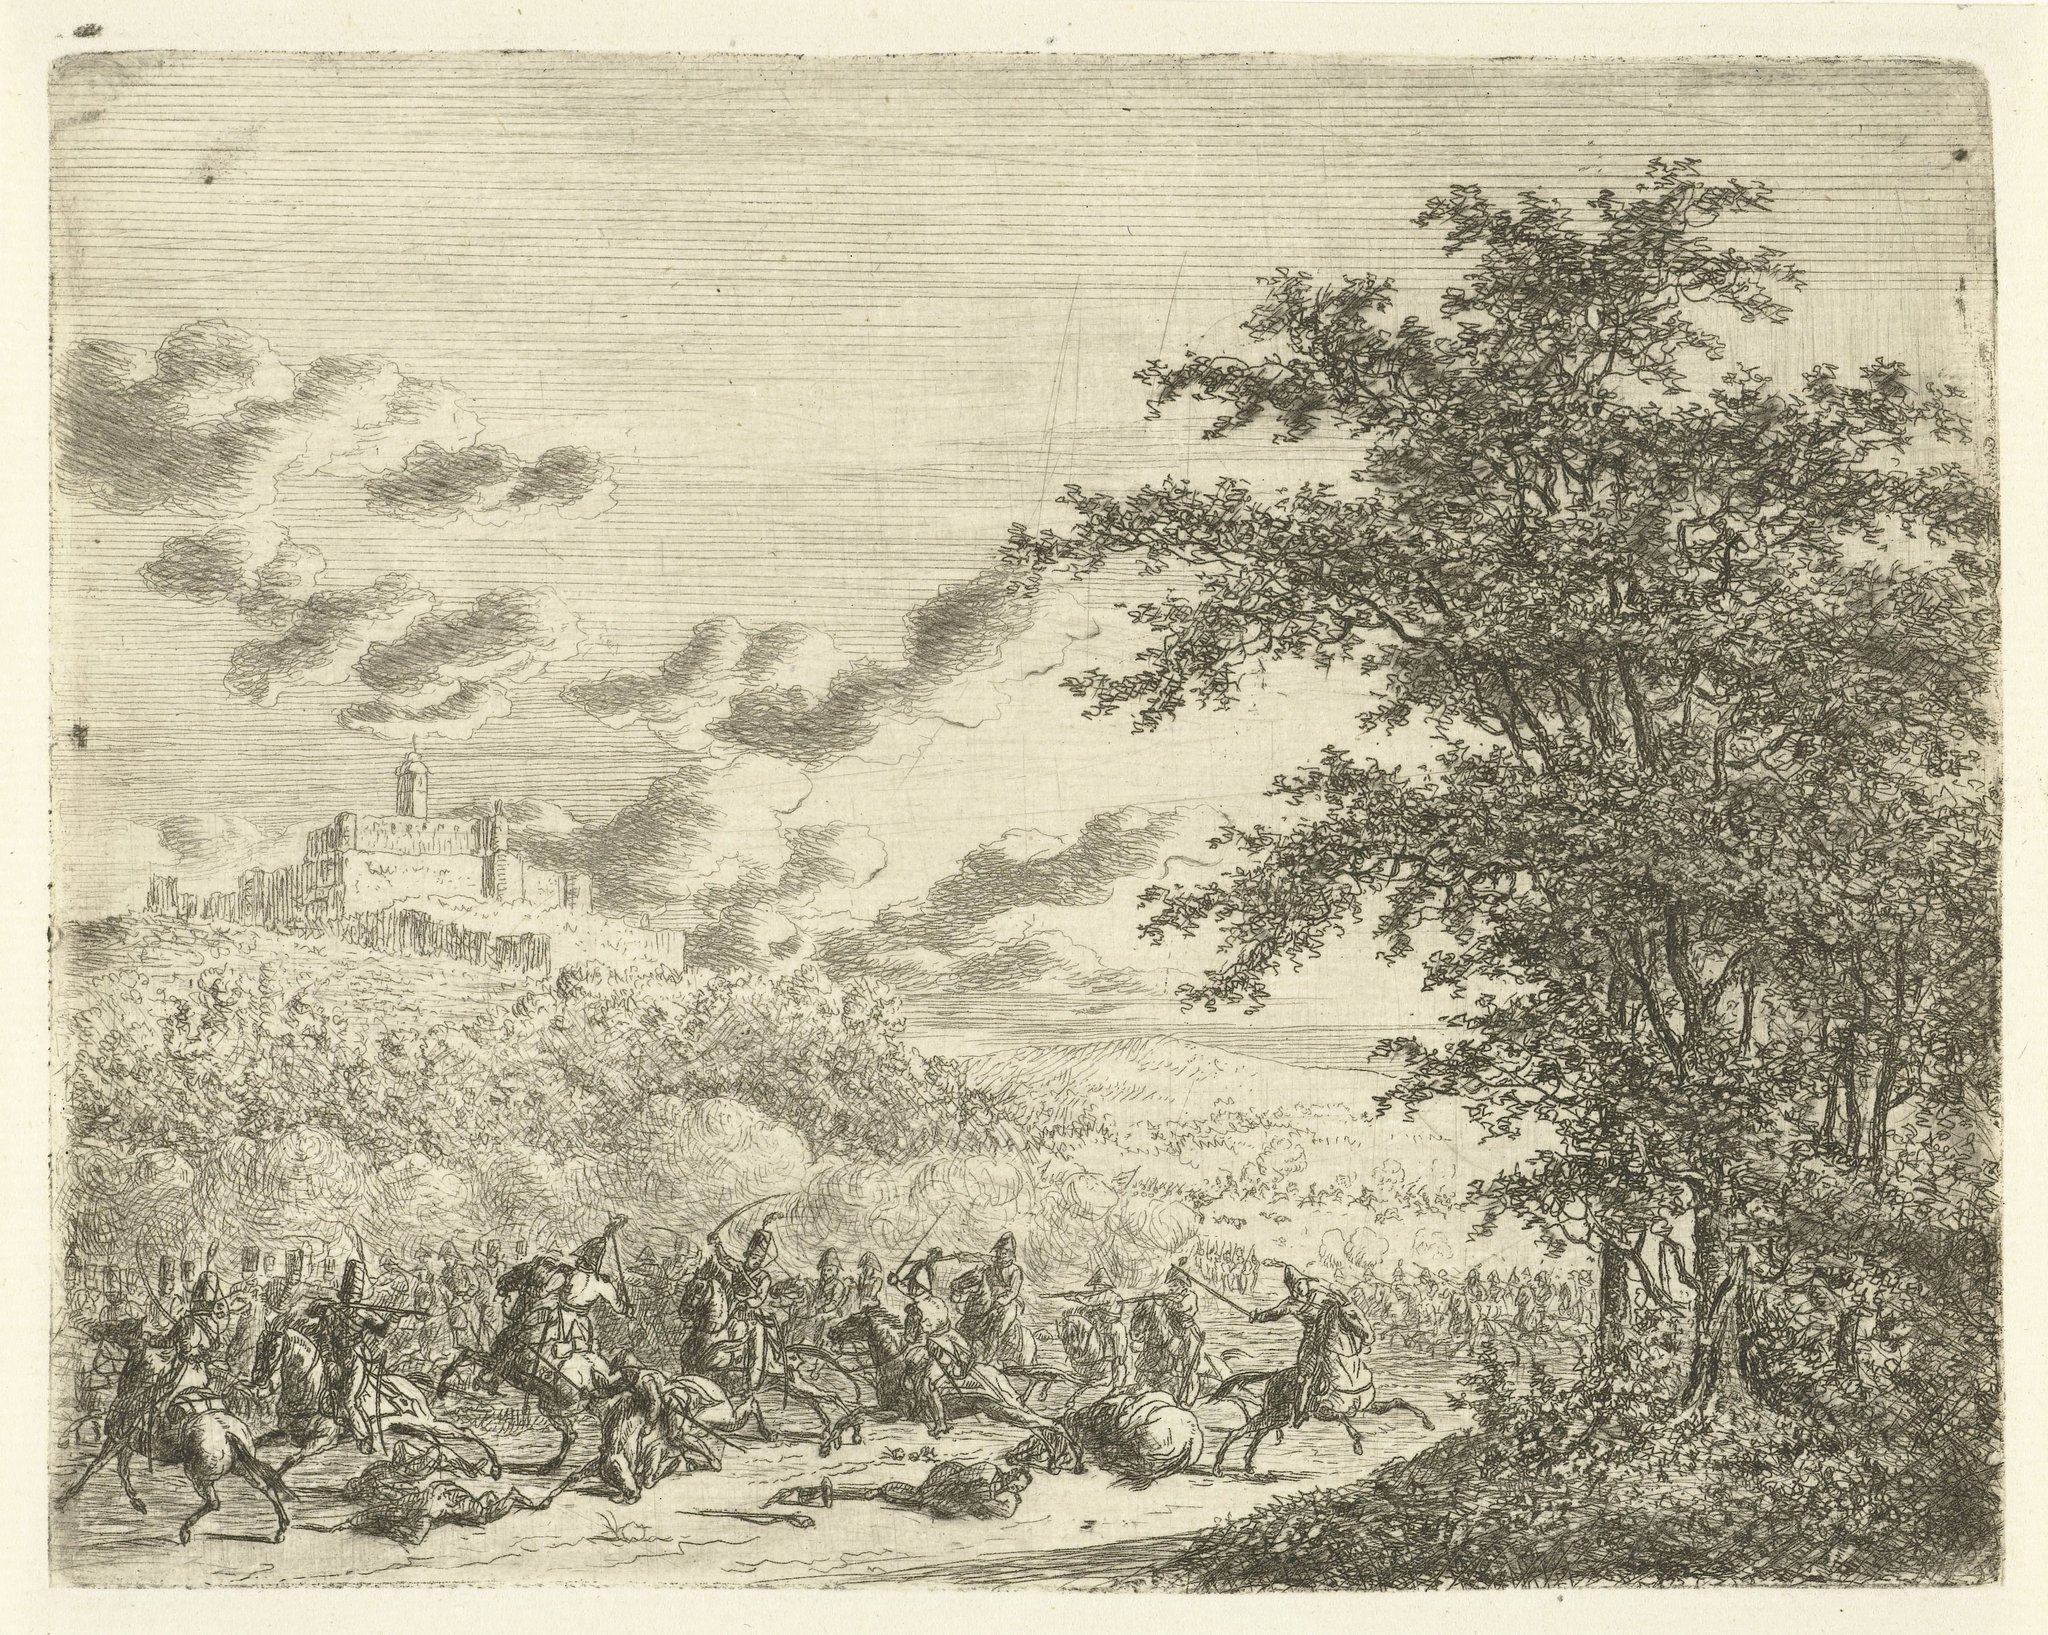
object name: print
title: Ruitergevecht bij fort Königstein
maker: gerardus emaus de micault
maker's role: draughtsman, print maker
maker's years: 1798-1863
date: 1813-1863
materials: paper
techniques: etching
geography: netherlands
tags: warfare; military affairs (+ cavalry, horsemen)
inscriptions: collector's mark: Lugt 2228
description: Op een vlakte met boompartij vindt een veldslag met cavaleristen plaats. Op een heuvel op de achtergrond het fort Königstein.